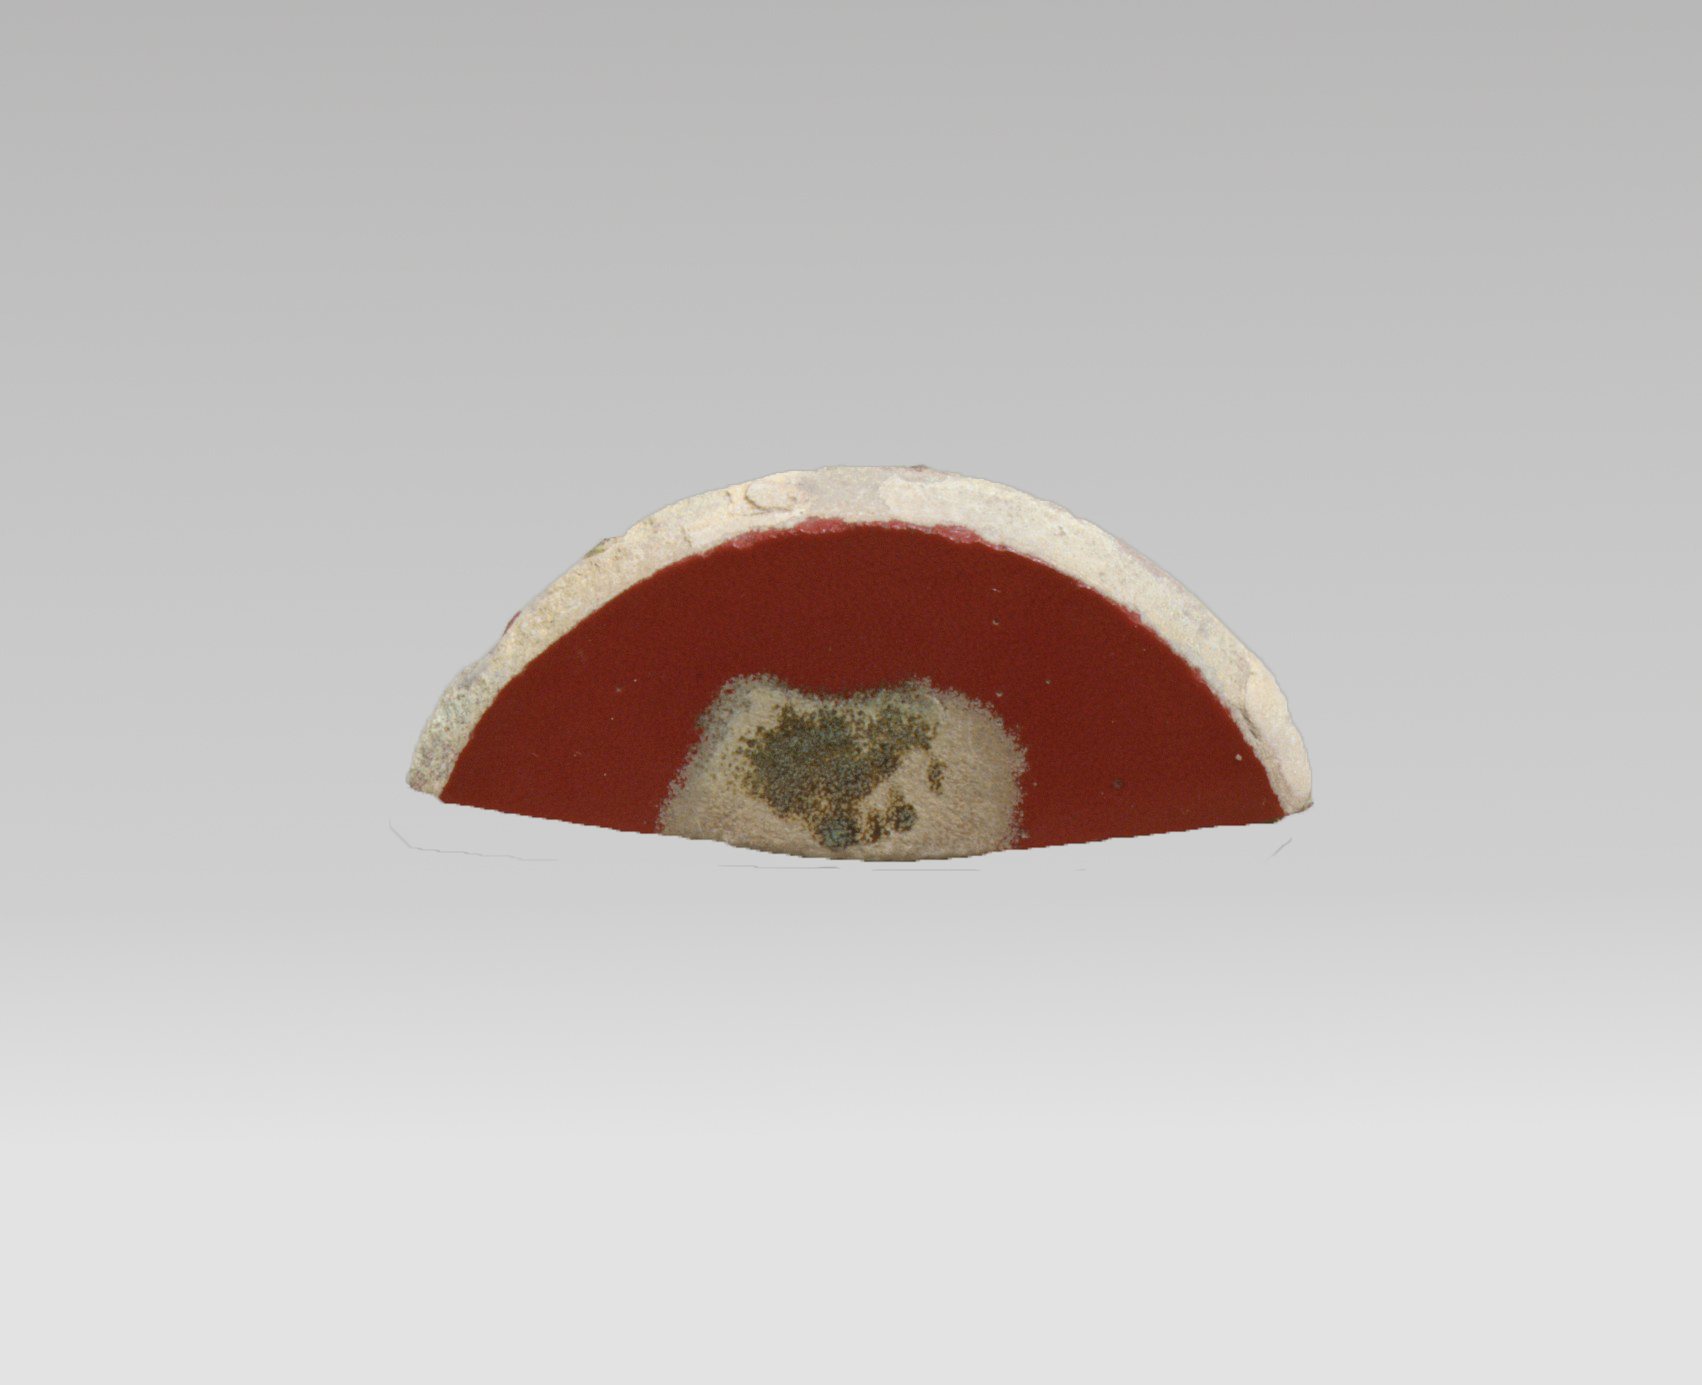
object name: fragment, monochrome, opaque red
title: Glass monocrome dish fragment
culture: roman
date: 1-50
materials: glass